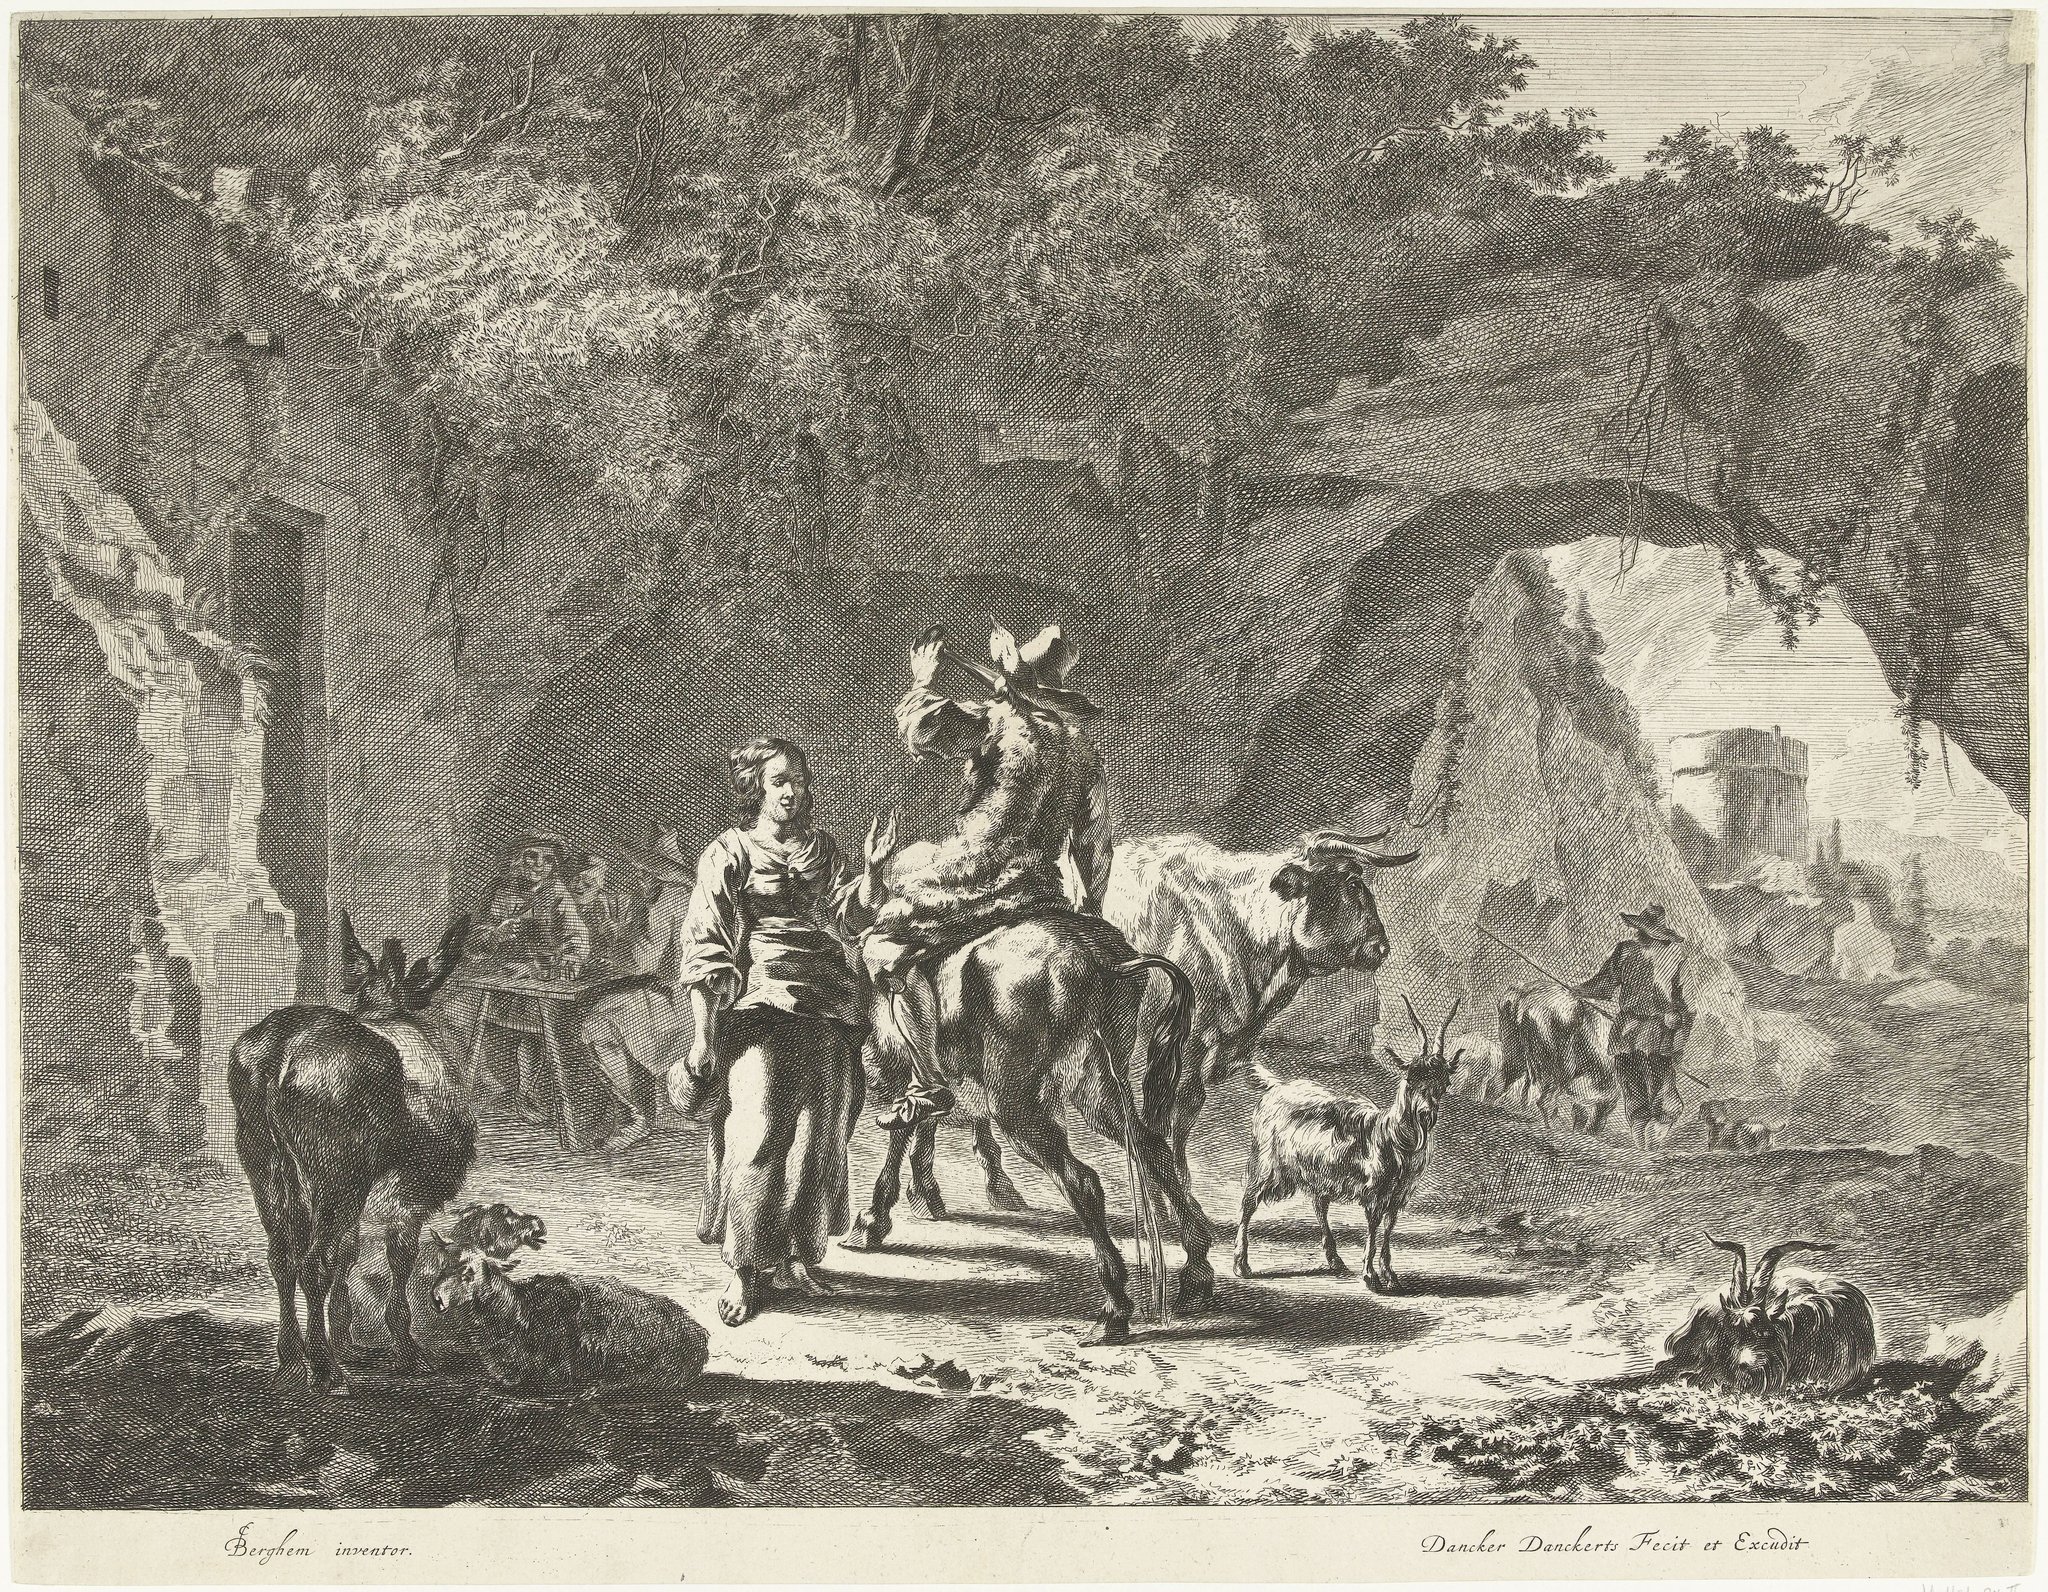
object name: print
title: Avond: herder bij herberg in rots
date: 1660-1666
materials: paper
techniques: etching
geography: amsterdam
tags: herding, herdsman, herdswoman, shepherd, shepherdess, cowherd, etc., inn, coffee-house, public house, etc., rocks, evening ~ other concepts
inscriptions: collector's mark: Lugt 240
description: Herder zittend op muilezel drinkt glas leeg terwijl het beest staat te plassen voor een herberg in een rots. Een groepje mannen drinkt en rookt aan een tafeltje voor een rotswand. Prent nummer 3 uit serie van vier prenten met tijden van de dag.